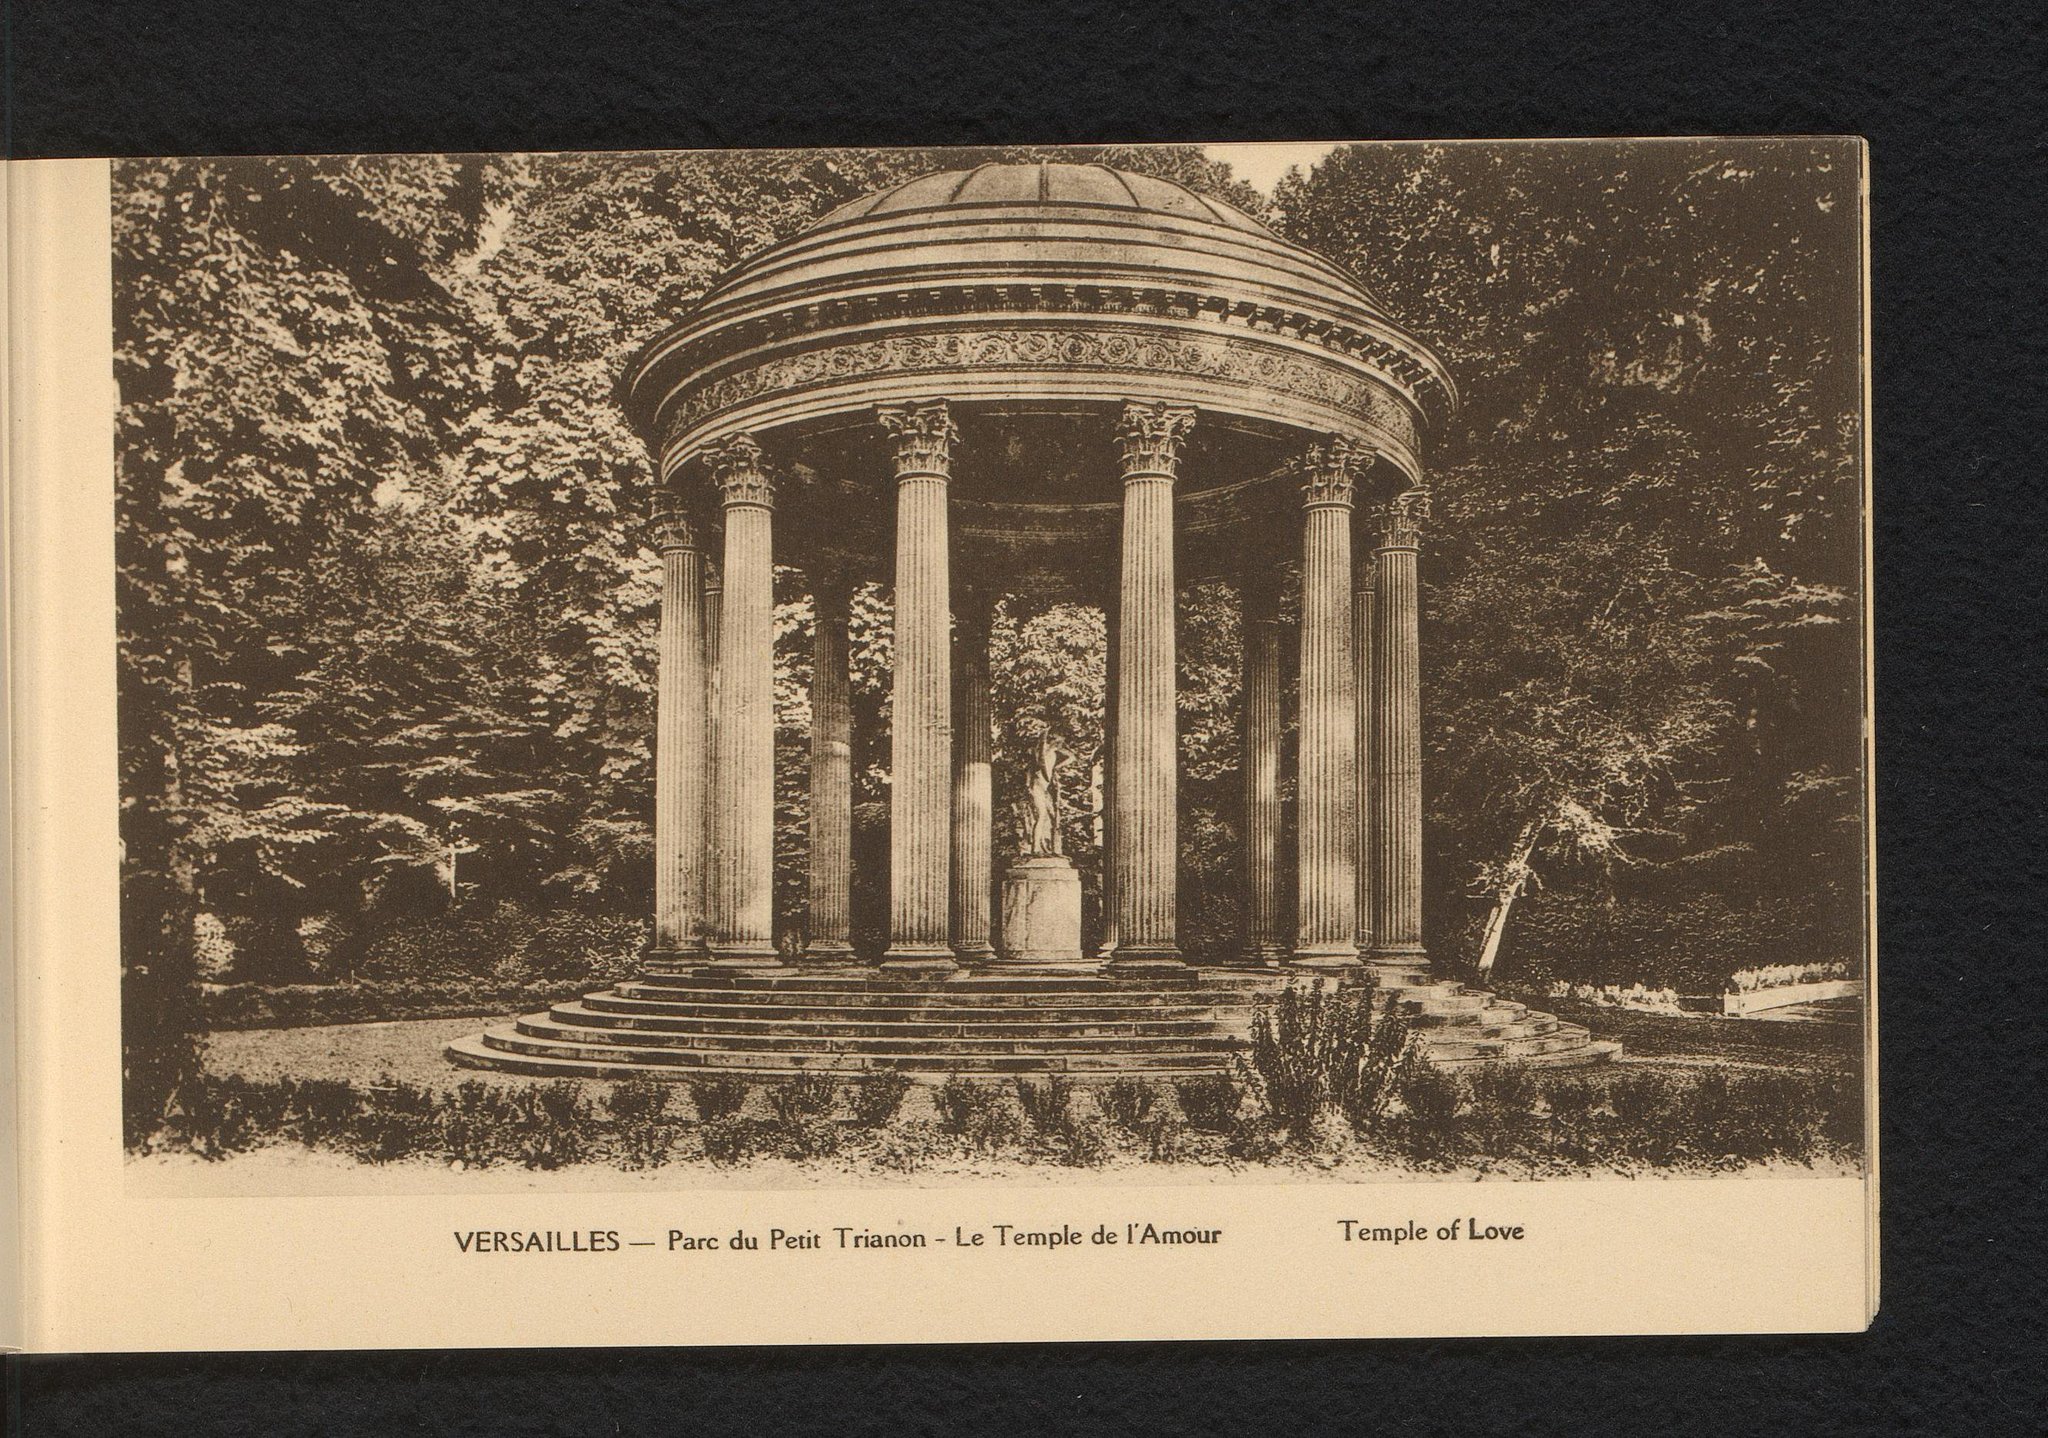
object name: photomechanical print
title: Versailles. Parc du Petit Trianon. Le Temple d'Amour / Temple of Love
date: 1919-1930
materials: cardboard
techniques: photograph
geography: paris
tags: french or architectonic garden; formal garden, garden ornaments